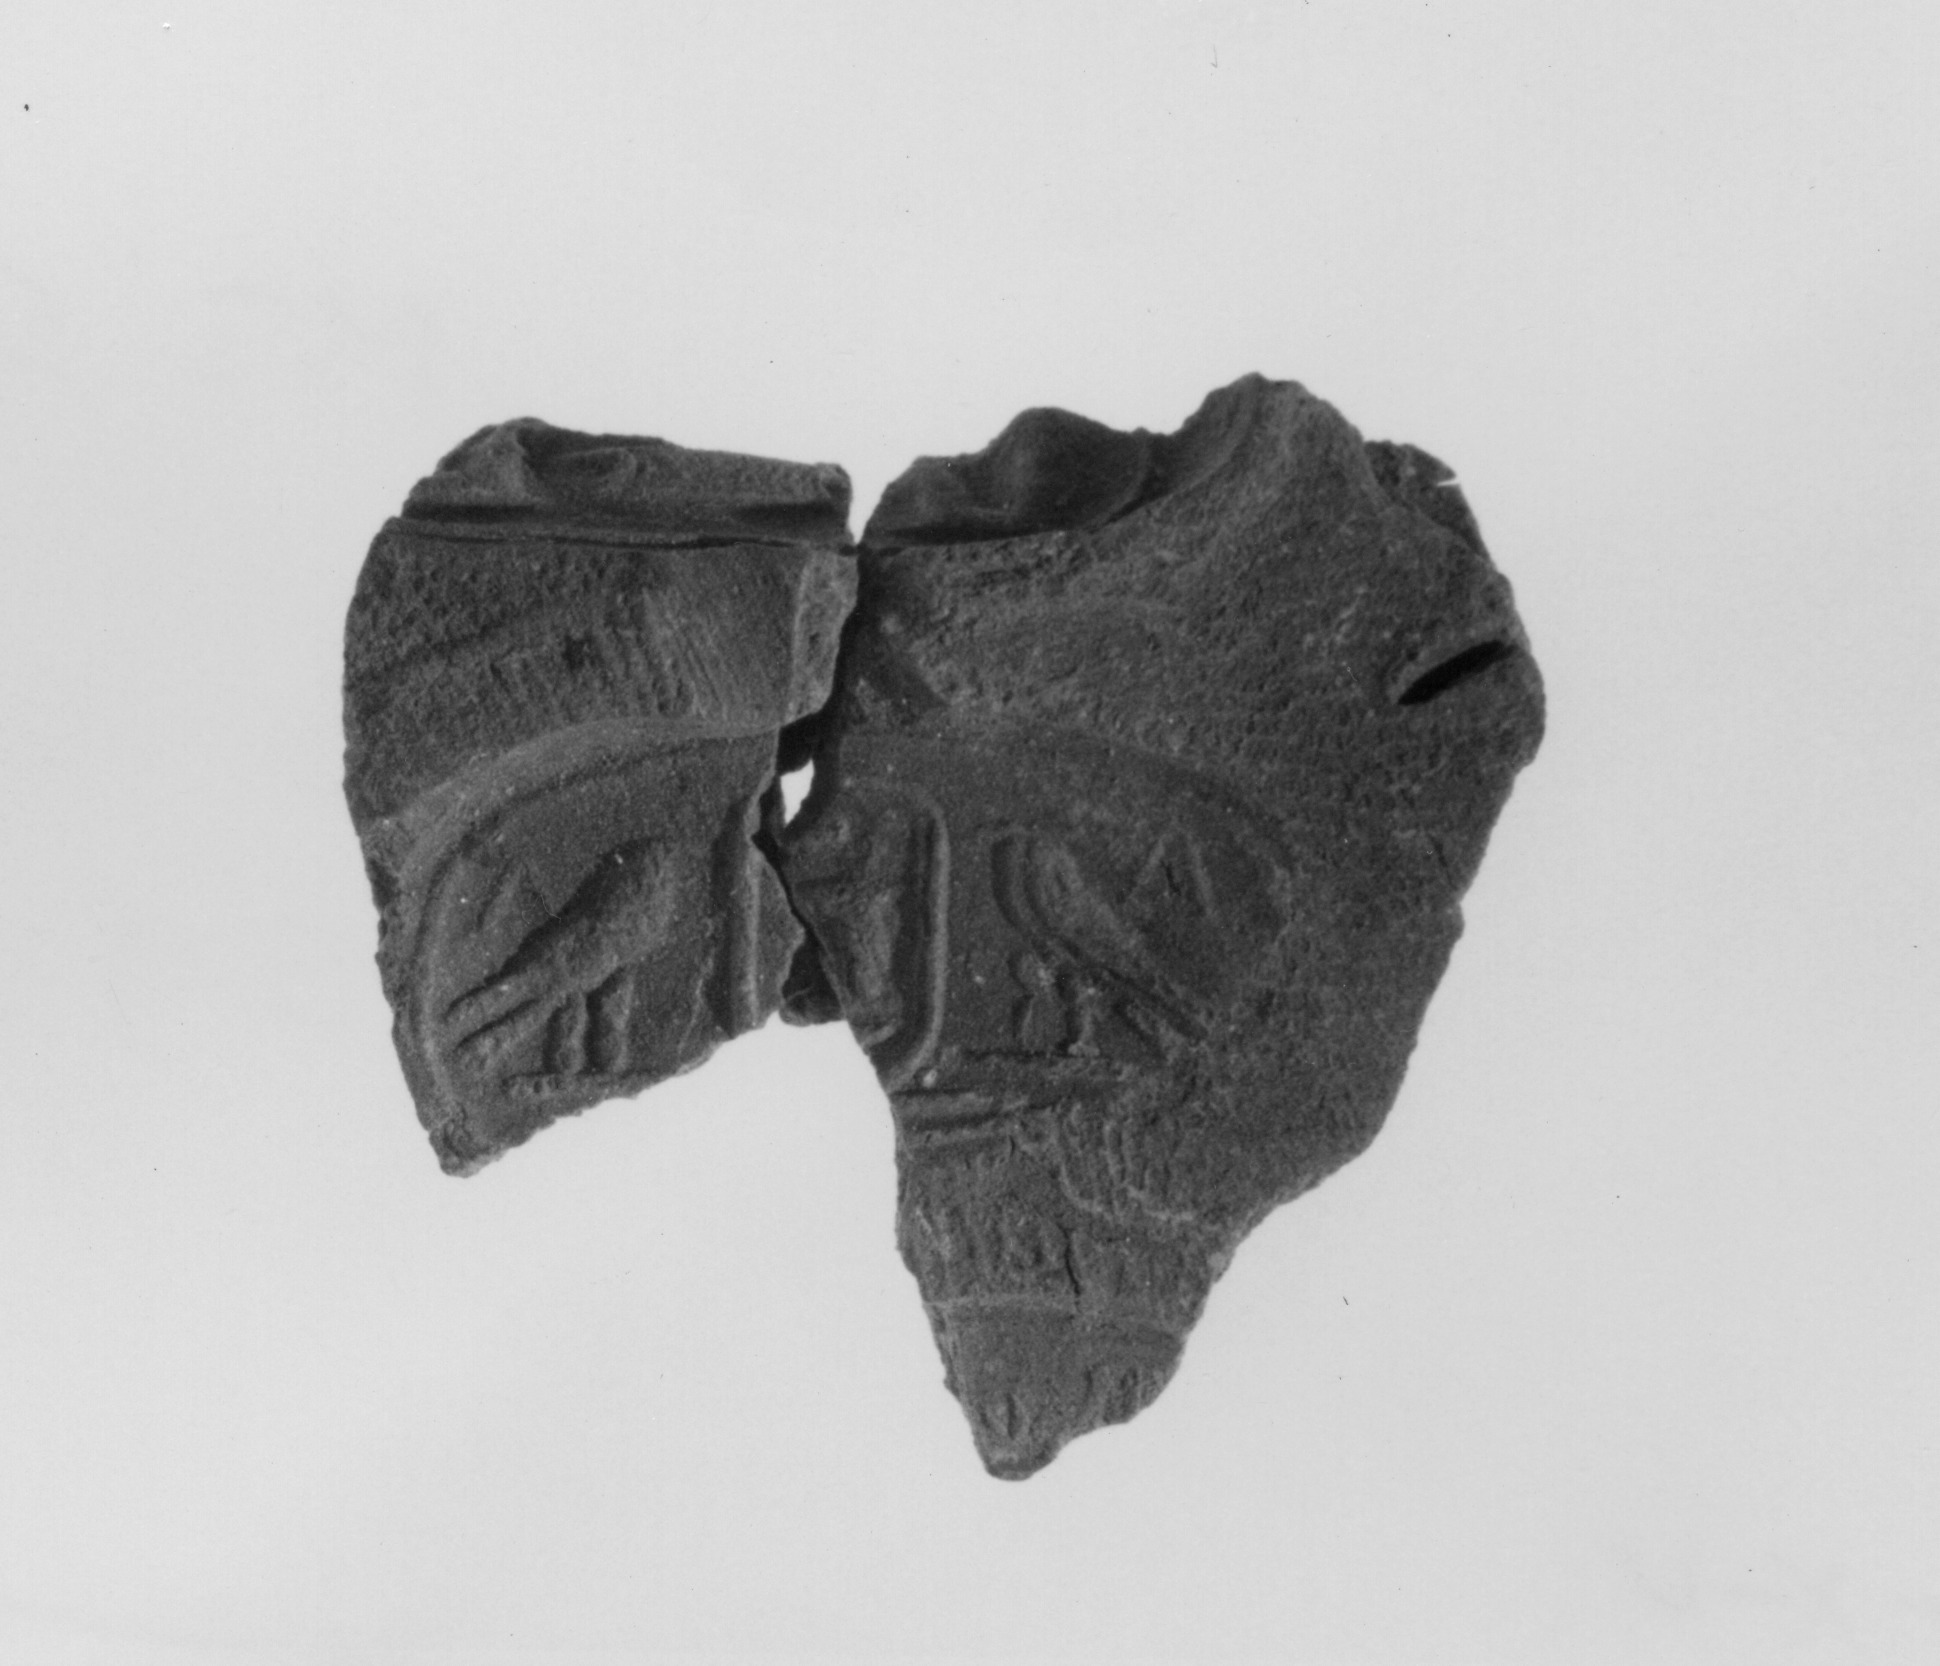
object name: sealing, amenhotep iii, nebmaatre, horus, falcon, thoth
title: Document Sealing With Multiple Seal Impressions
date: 1390-1352 BCE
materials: mud